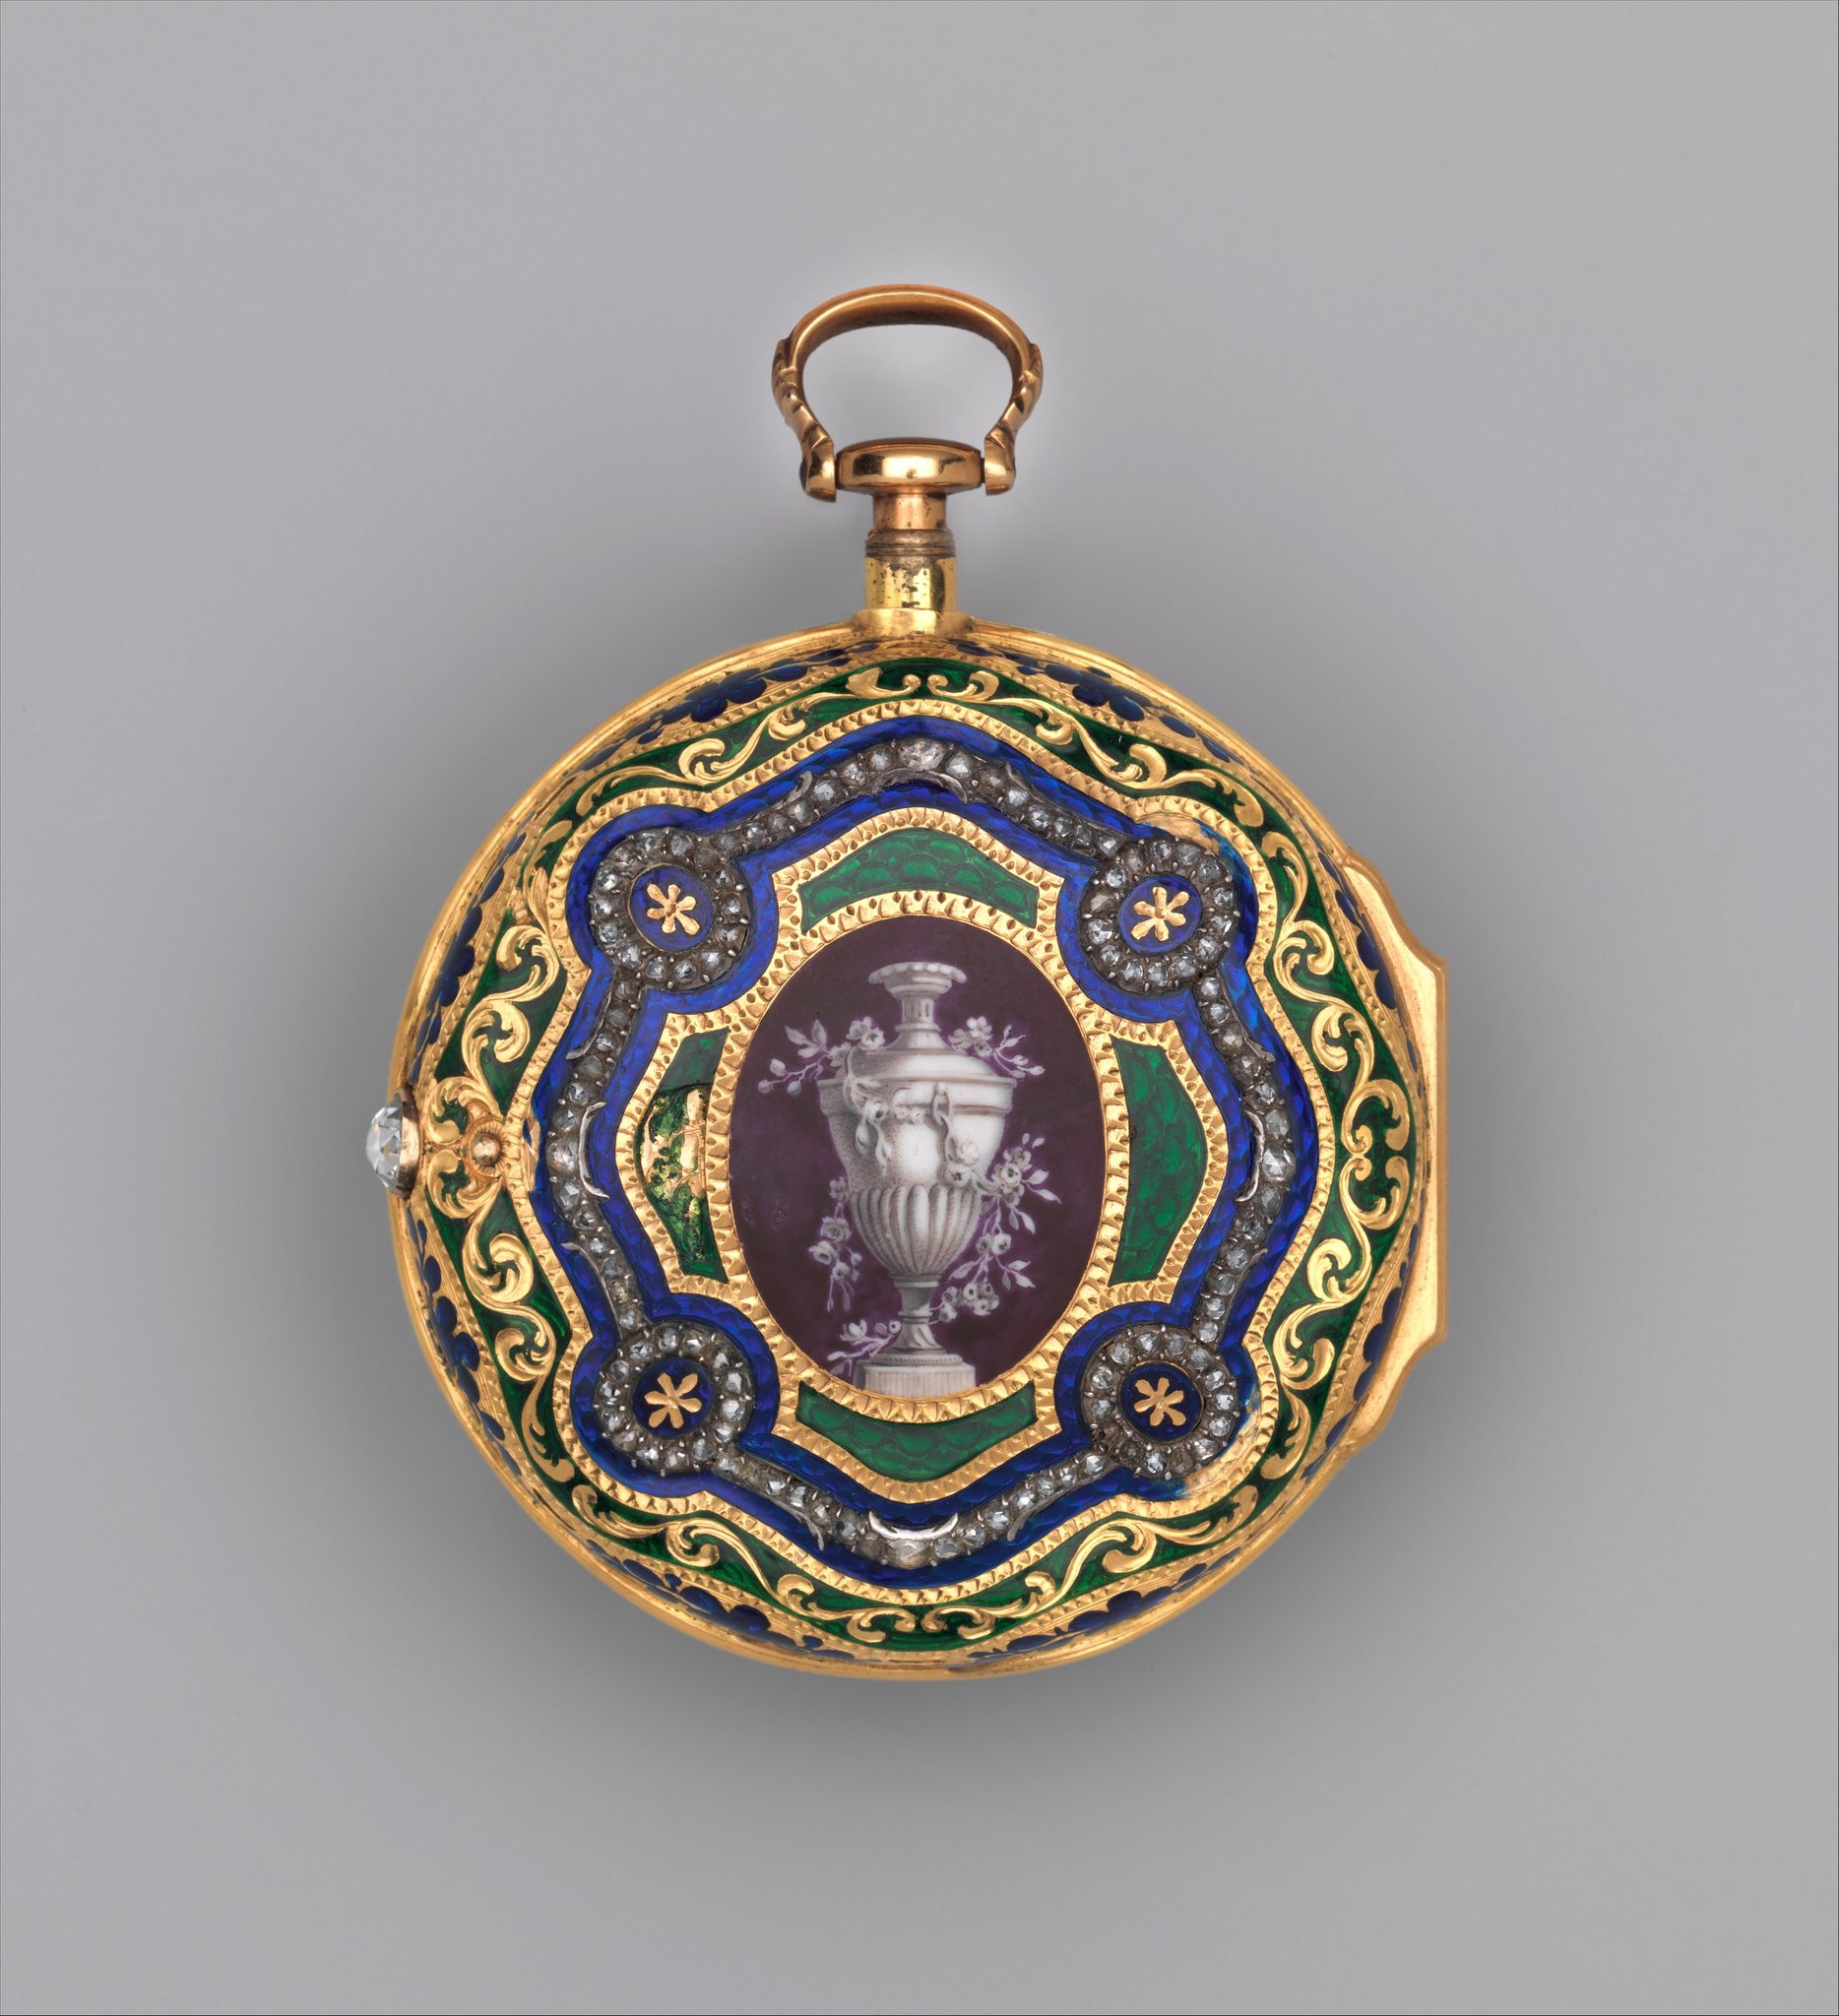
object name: watch case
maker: george harrison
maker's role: maker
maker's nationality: british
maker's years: 1730-1790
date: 1770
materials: diamond, gold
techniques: enamel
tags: flowers,urns